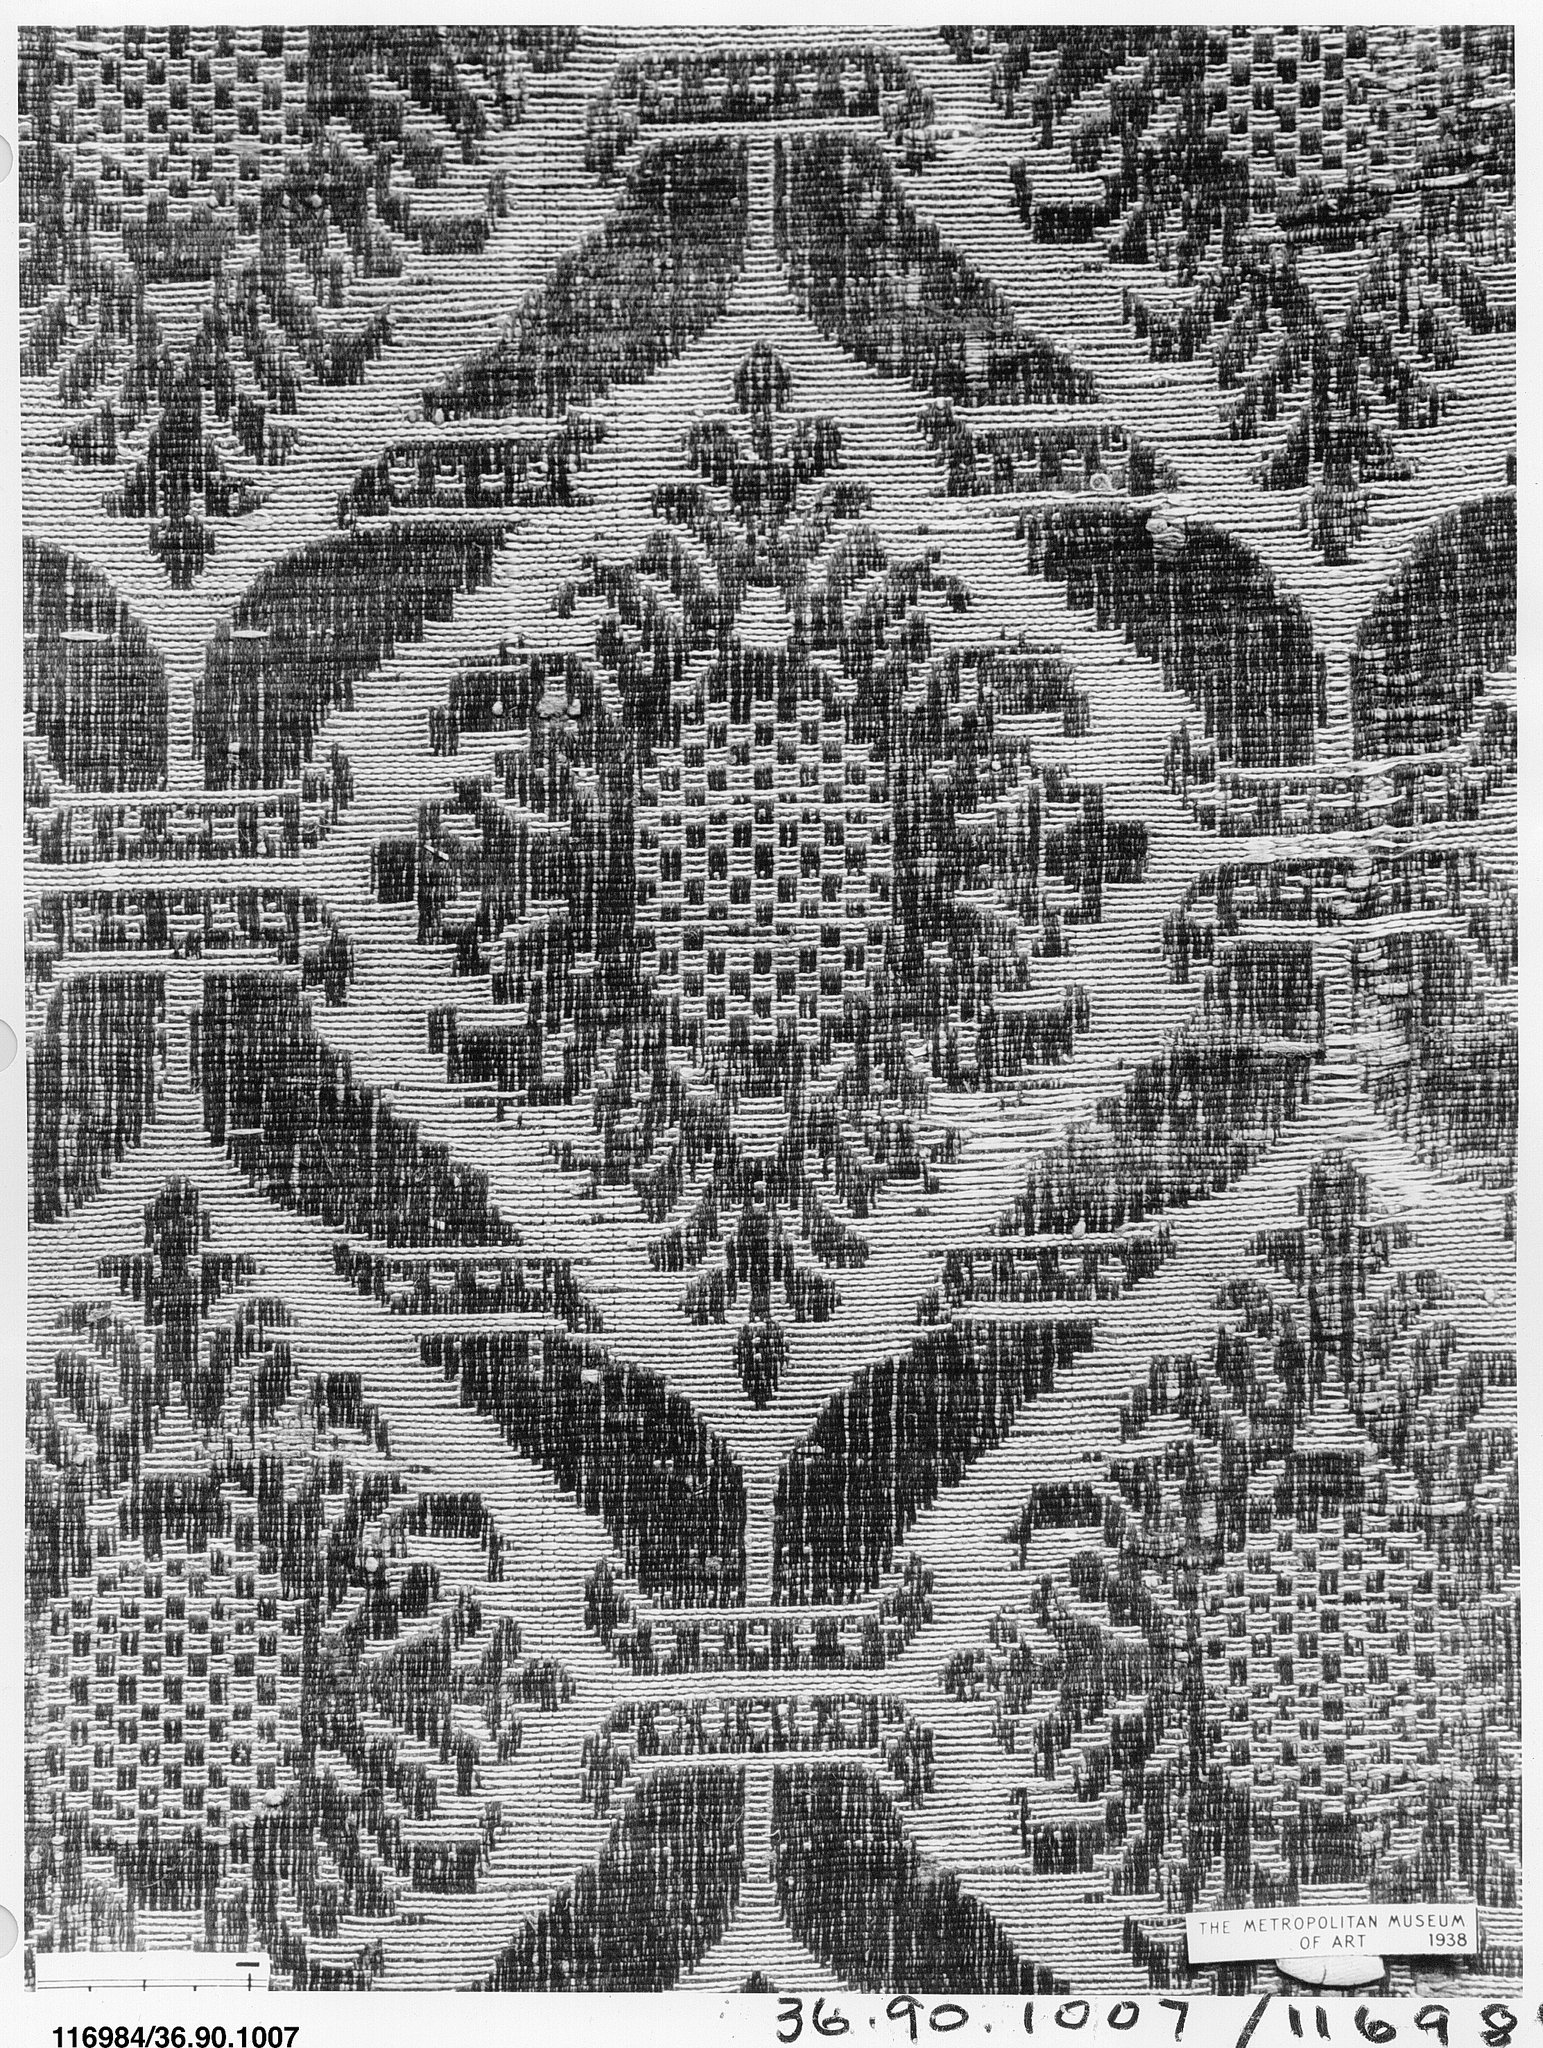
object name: piece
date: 1501-1600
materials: cotton, silk